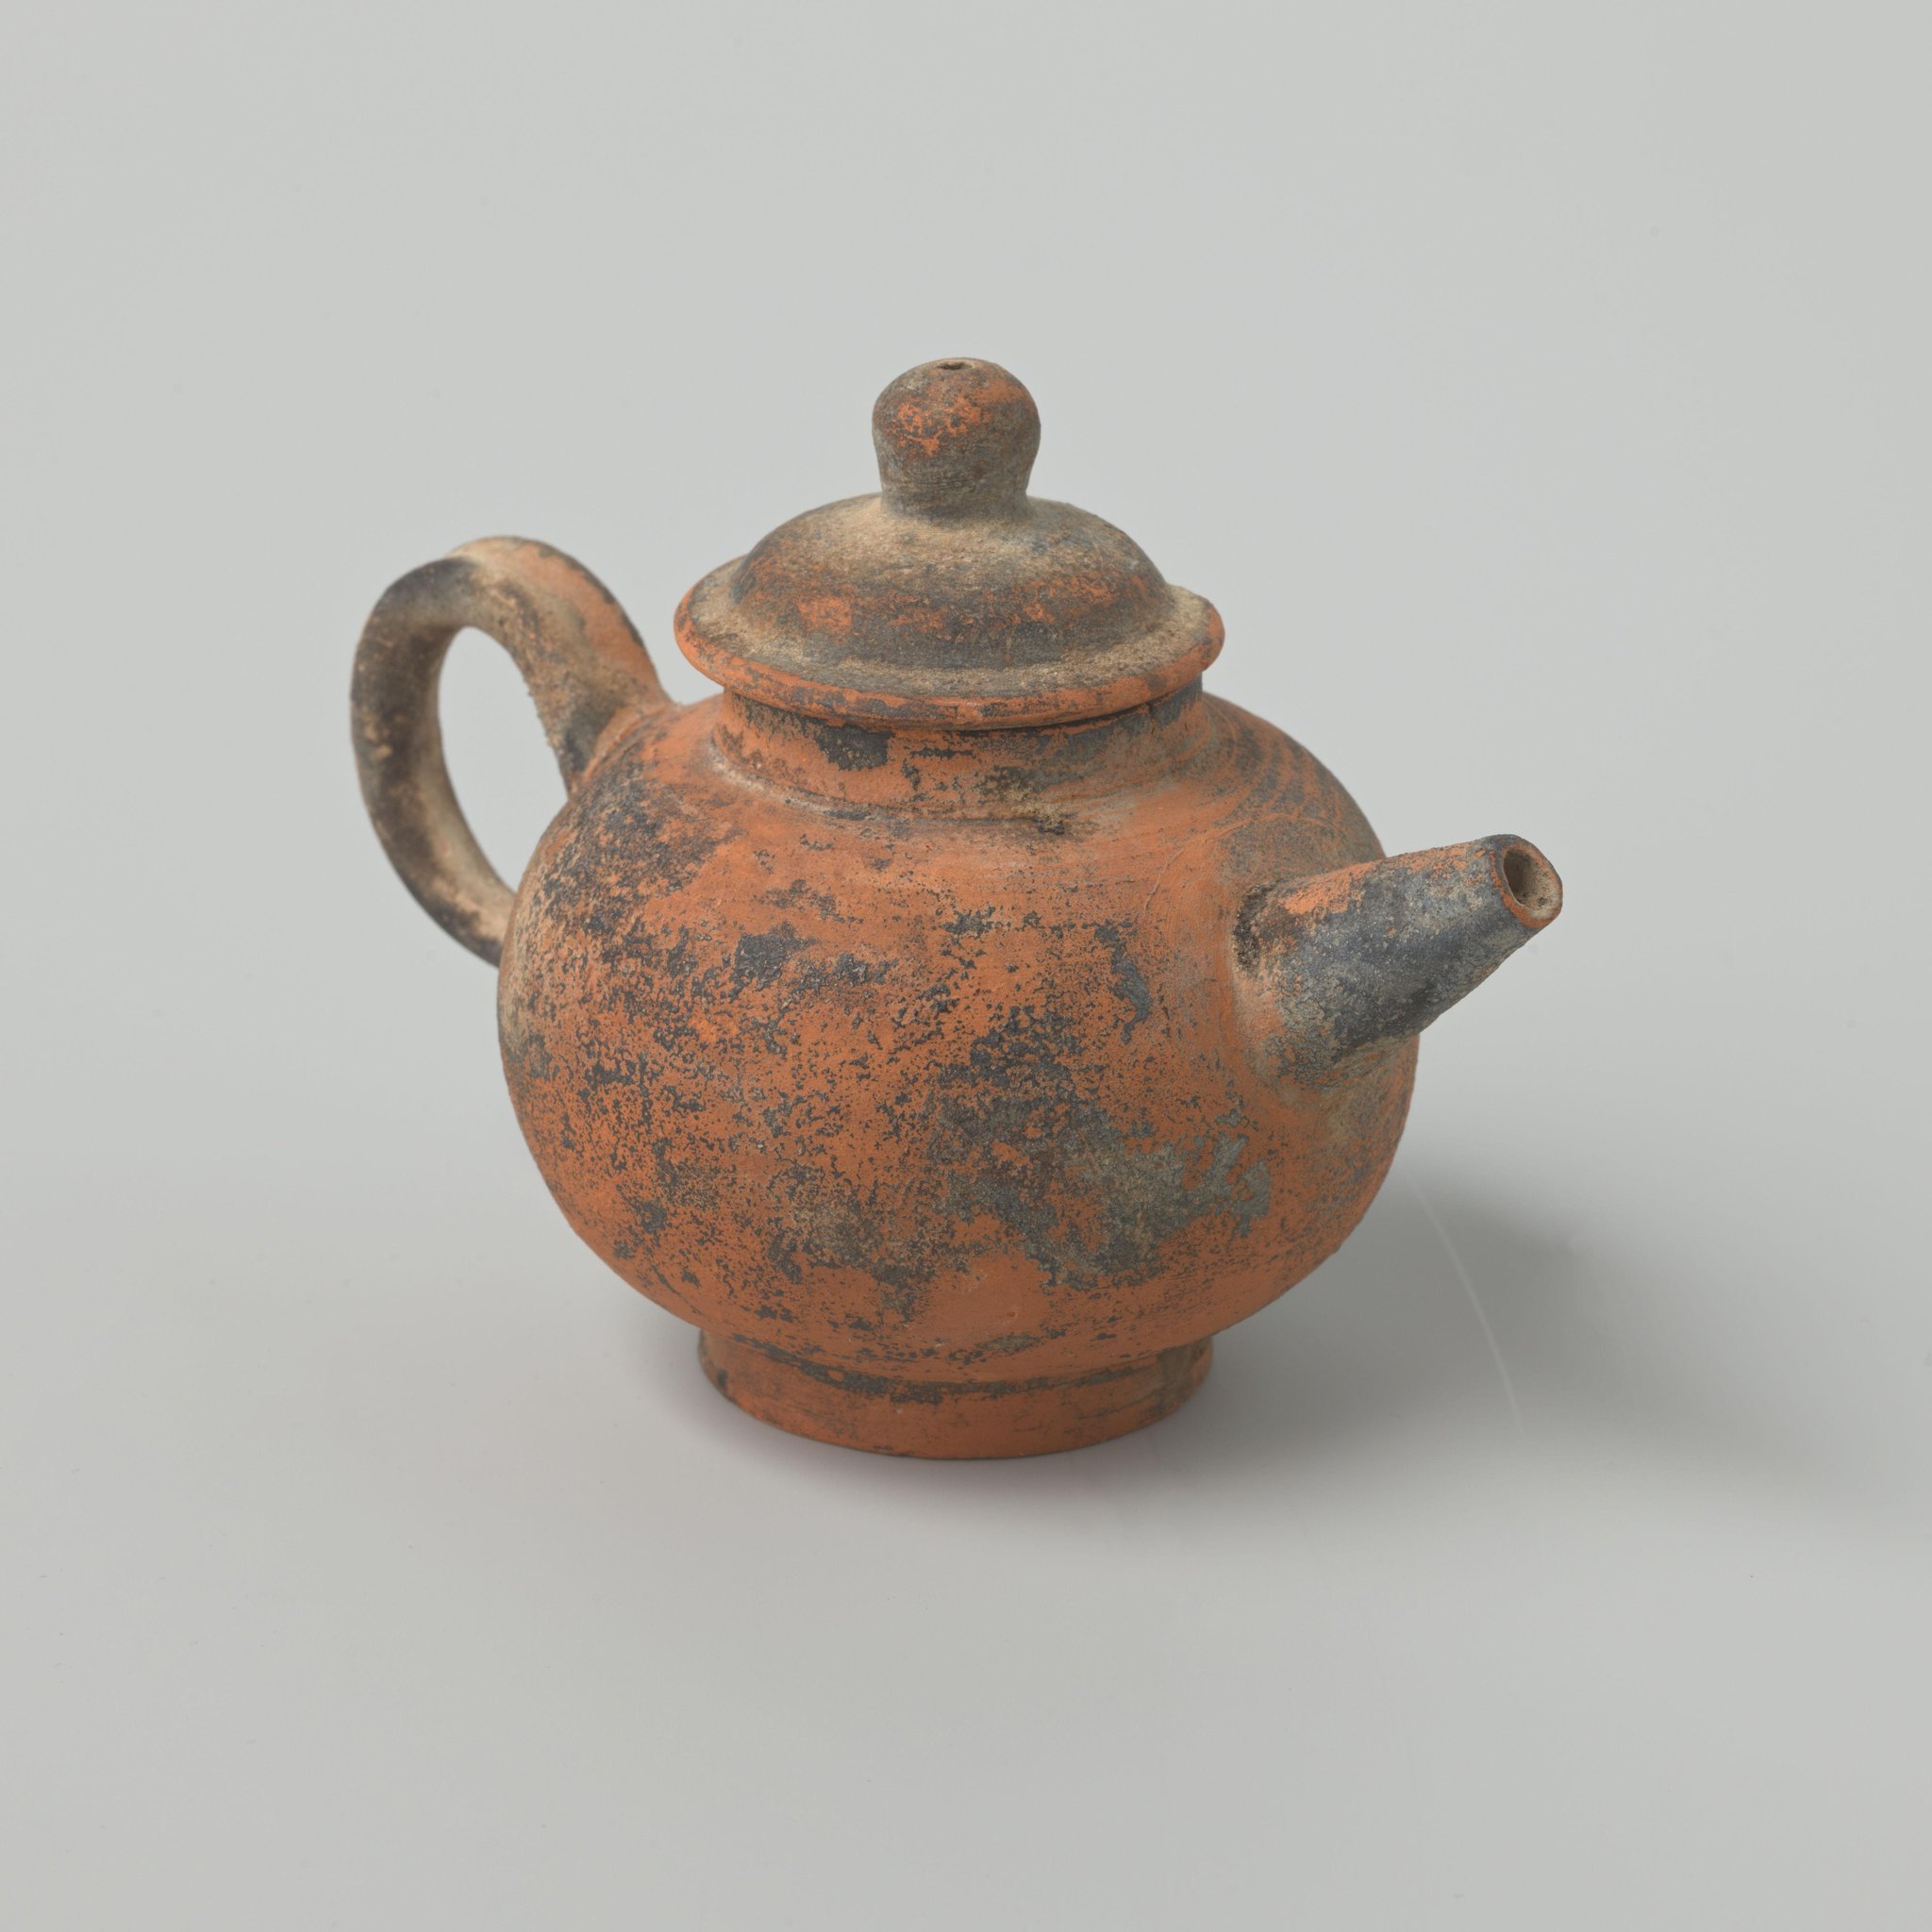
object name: bakafval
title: Theepot van ongeglazuurd aardewerk (De Caluwe bakafval)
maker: jacobus de caluwe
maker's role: plateelbakkerij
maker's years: -1730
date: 1700-1725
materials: earthenware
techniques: firing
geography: delft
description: Toegeschreven aan Jacobus de Caluwe, omdat dit voorwerp samen met gemerkte stukken (‘Jacobus De Caluwe’ en rennend hert) gevonden is op de plaats waar zich De Caluwes tweede werkplaats bevond. Er is een duidelijke stilistische overeenkomst tussen de gemerkte en niet gemerkte voorwerpen uit deze archeologische vondst.